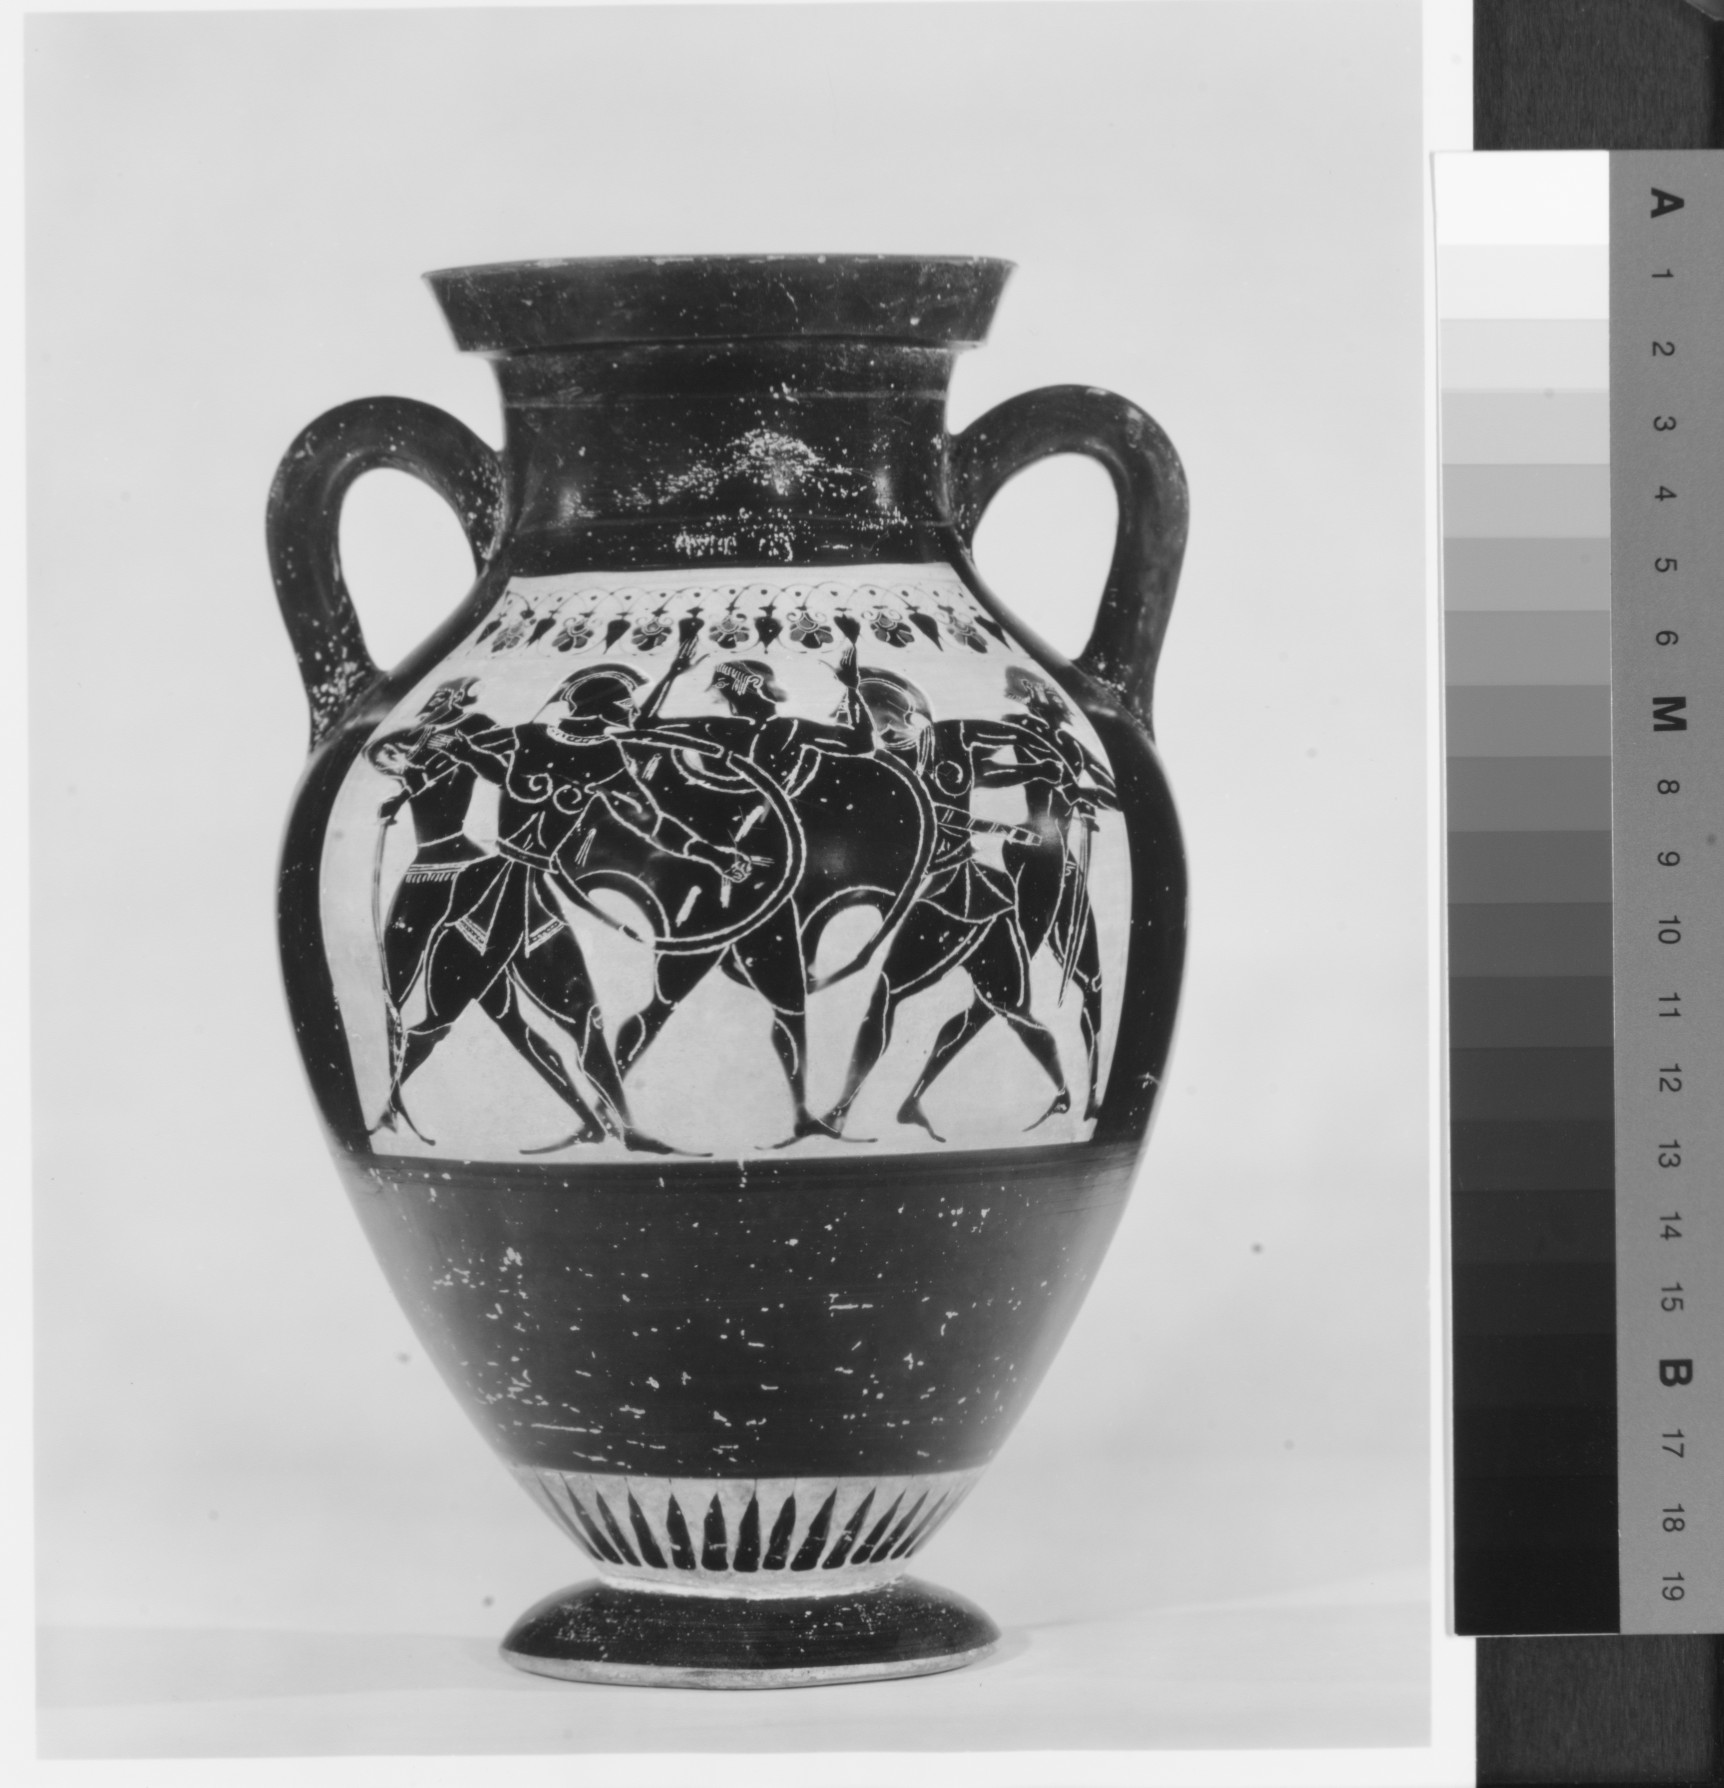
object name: amphora, type b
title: Terracotta amphora (jar)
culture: greek, attic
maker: swing painter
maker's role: artist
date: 540-530 BCE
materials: terracotta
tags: musical instruments,men,dancing,musicians